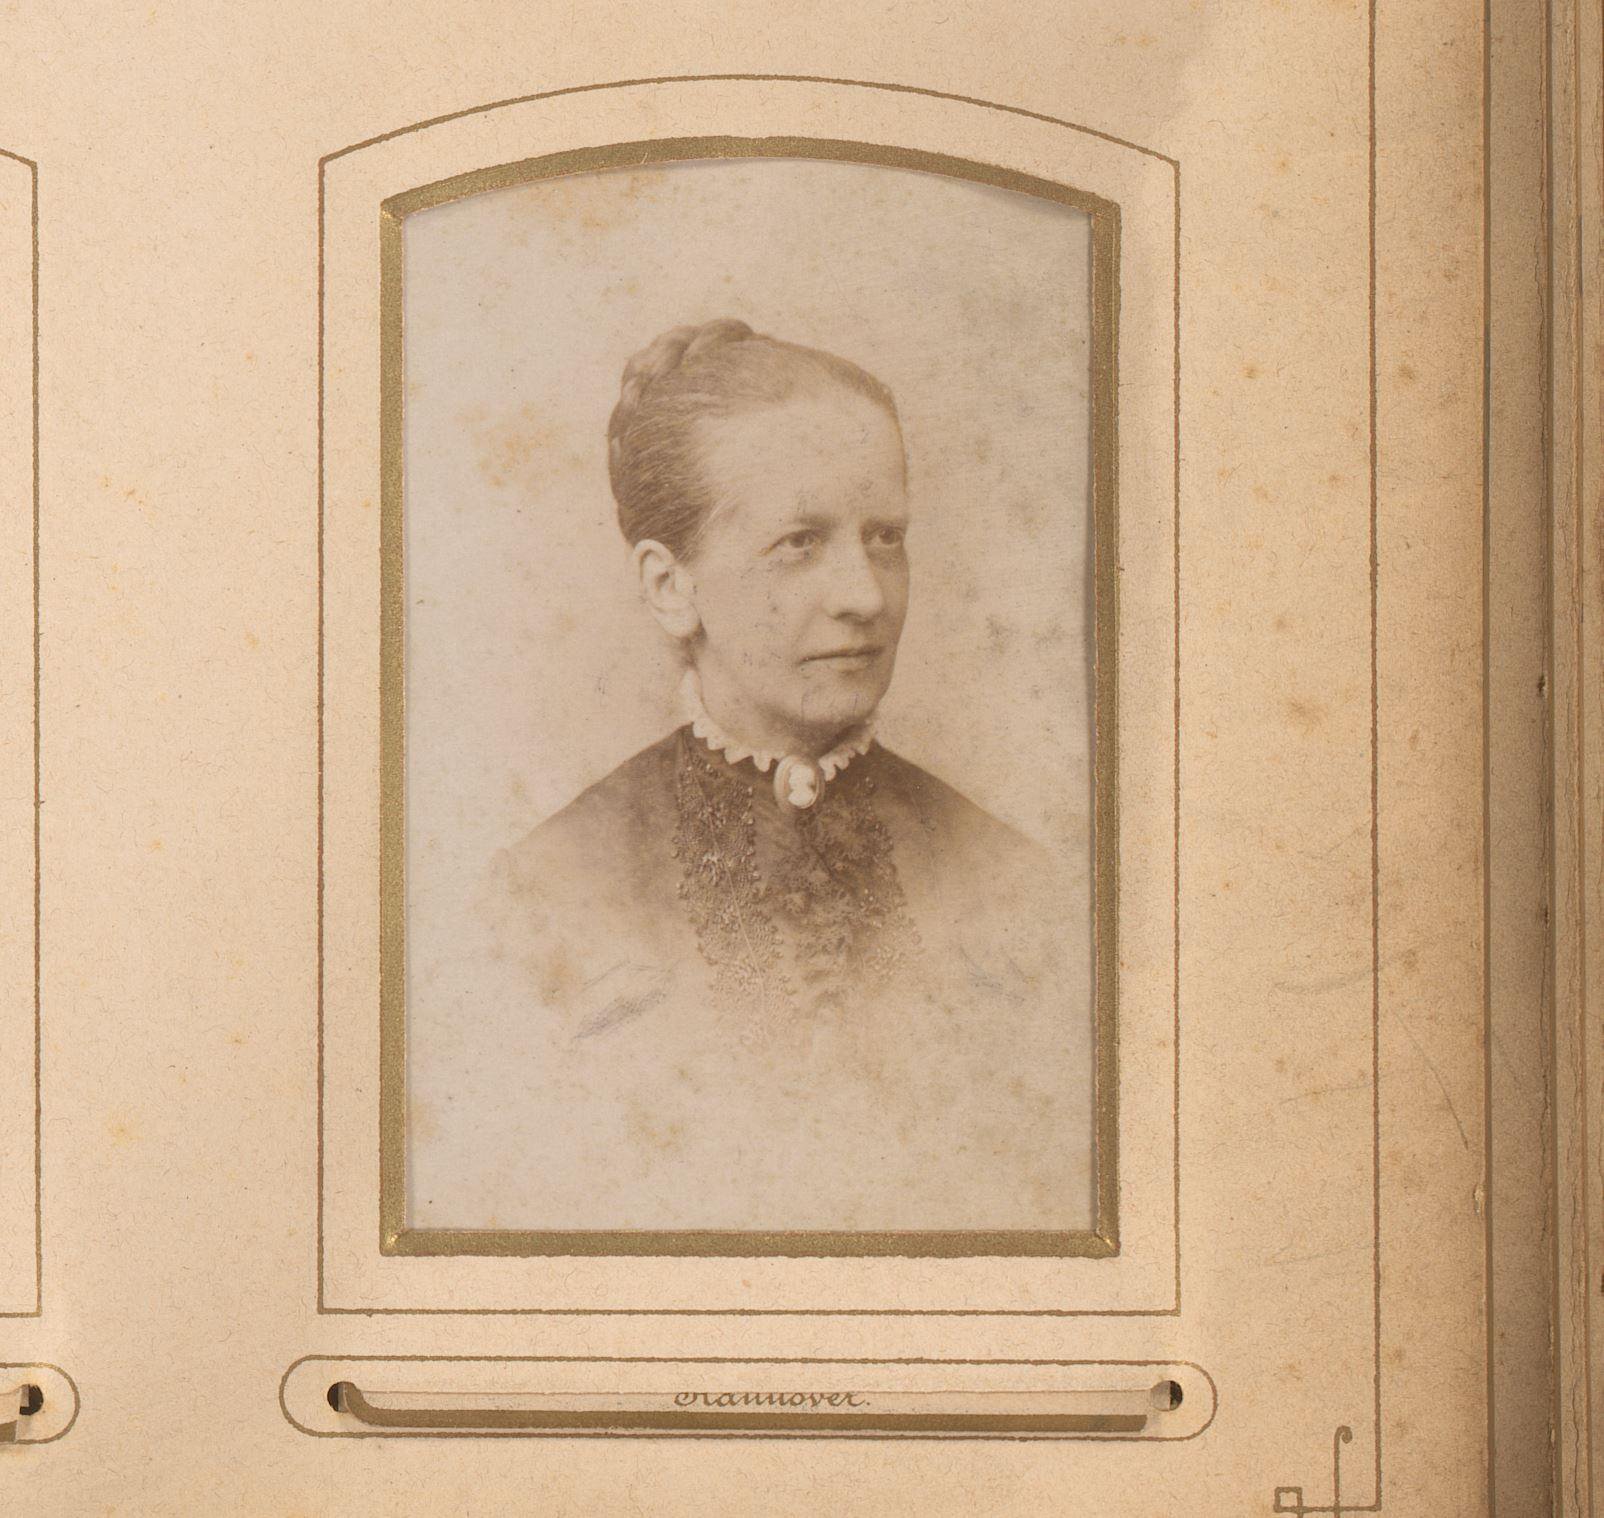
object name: photograph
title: Portret van een vrouw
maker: karl friedrich wunder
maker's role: fotograaf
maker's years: 1849-1924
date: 1870-1900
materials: cardboard, photographic support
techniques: albumen print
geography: hannover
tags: historical persons - bb - woman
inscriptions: inscription: ‘Karl F. Wunder/ Hannover/ Friedrichstrasse’